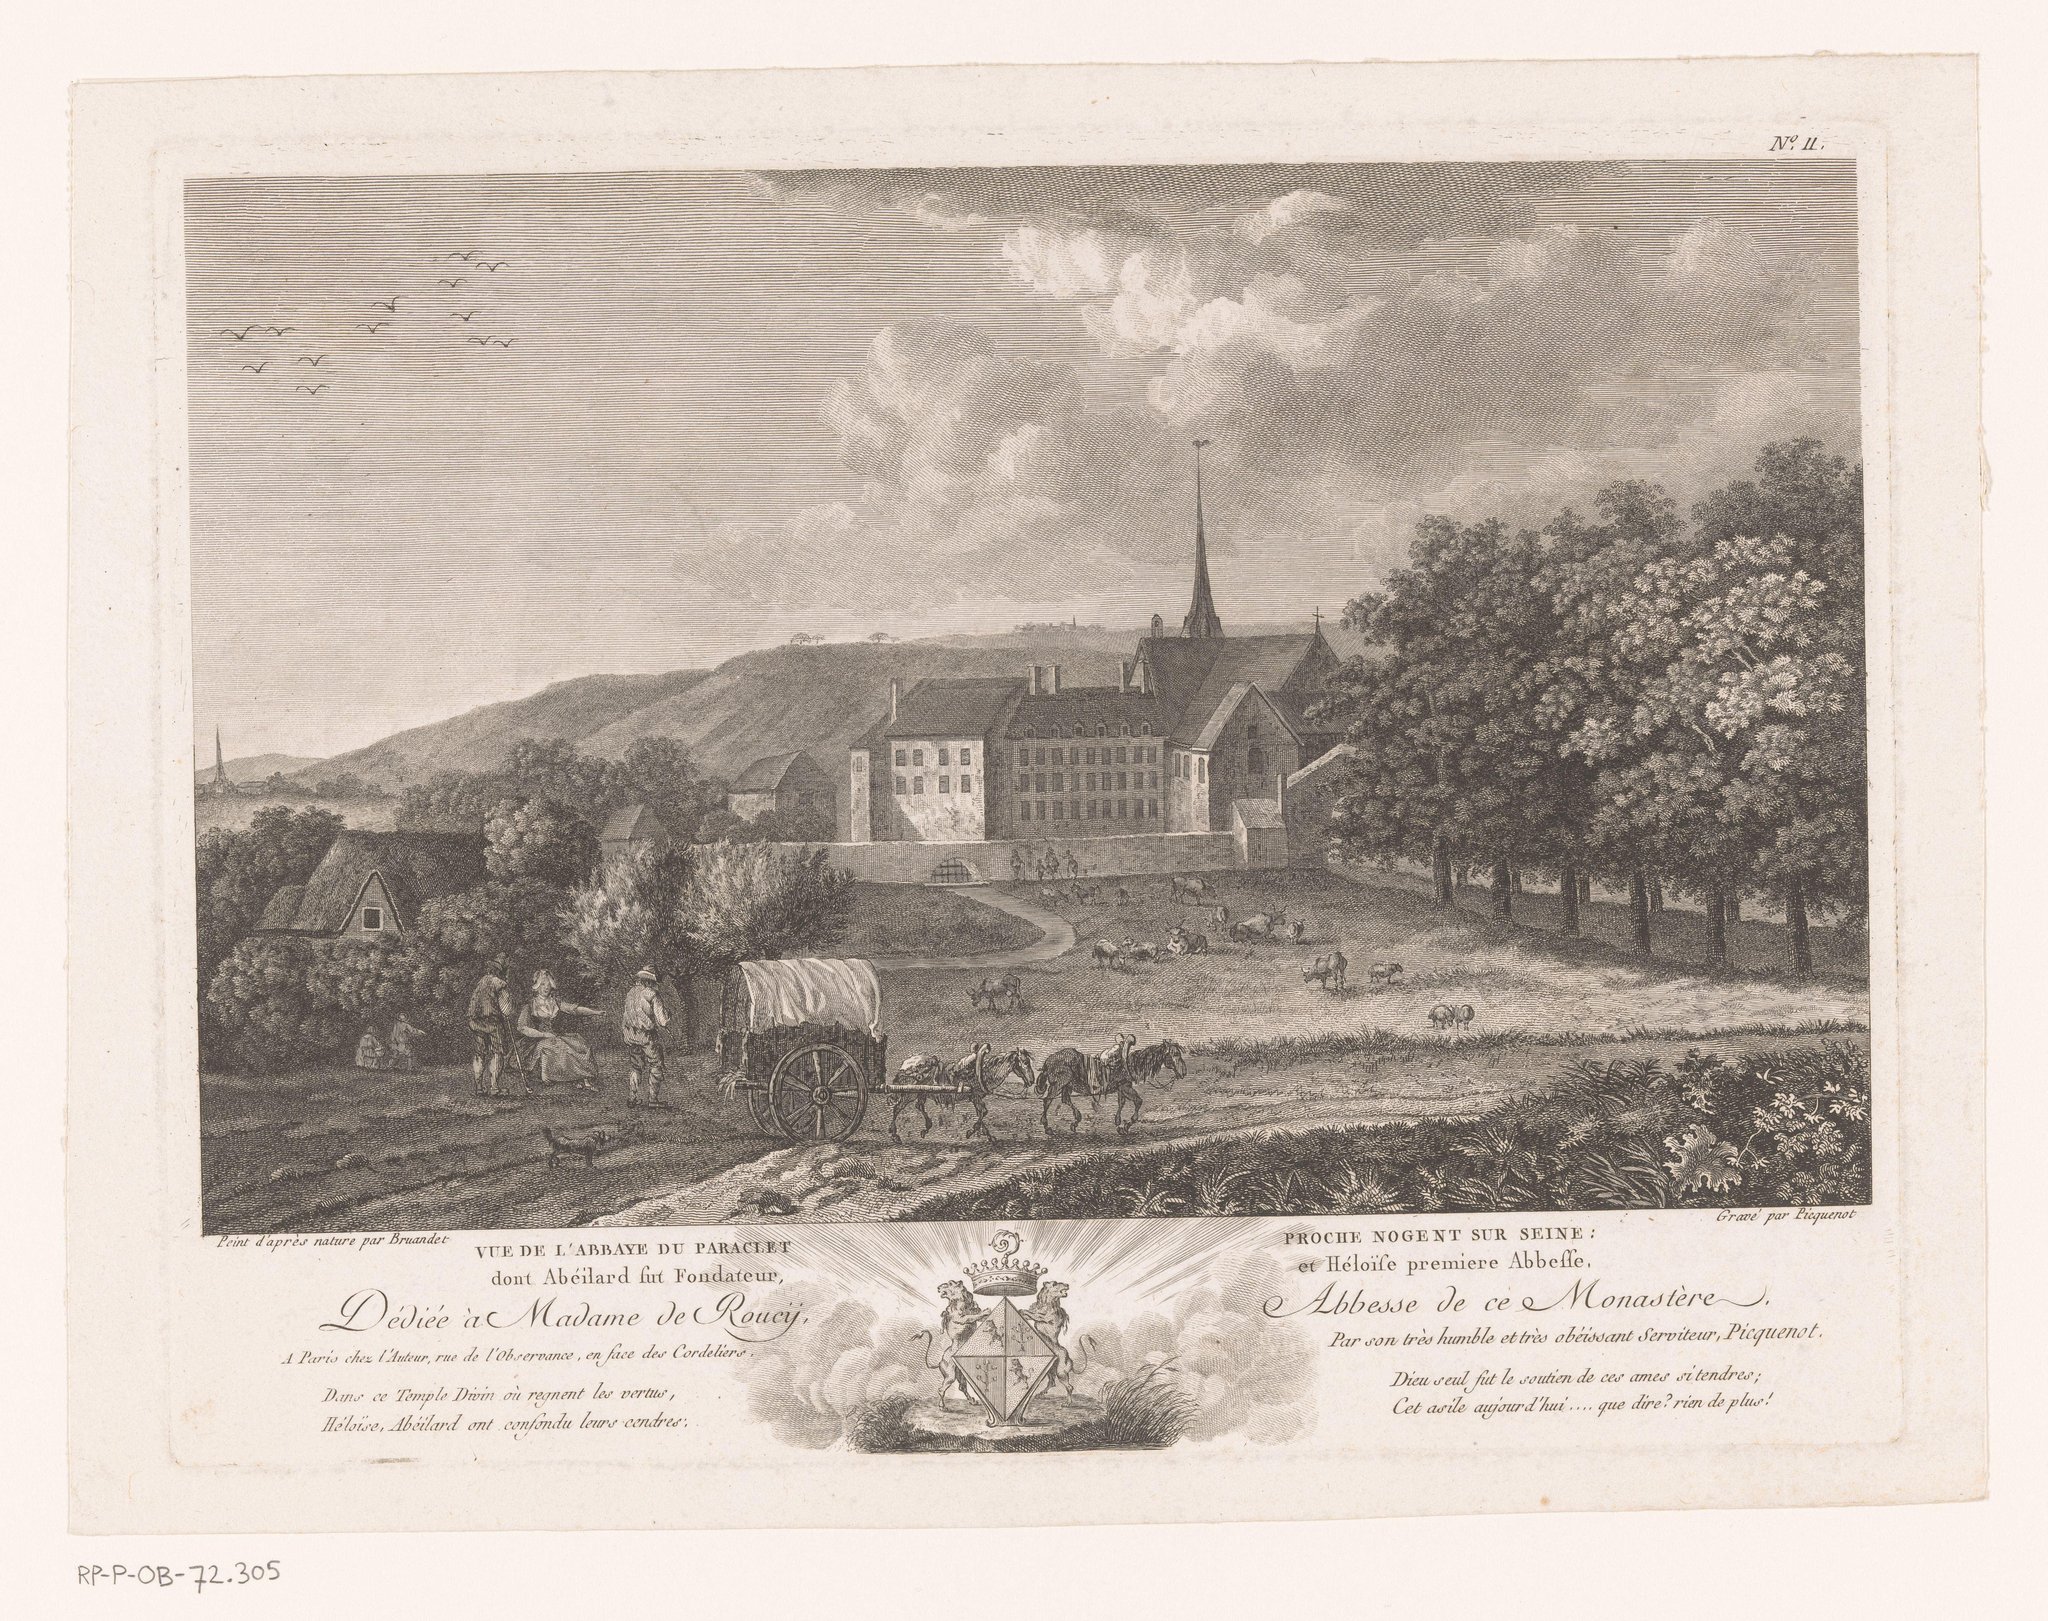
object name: print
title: Abdij van Paraclet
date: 1757-1814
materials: paper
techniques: engraving, etching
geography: paris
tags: city-view, and landscape with man-made constructions, abbey, monastery, convent ~ roman catholic church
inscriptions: collector's mark: Lugt 2228